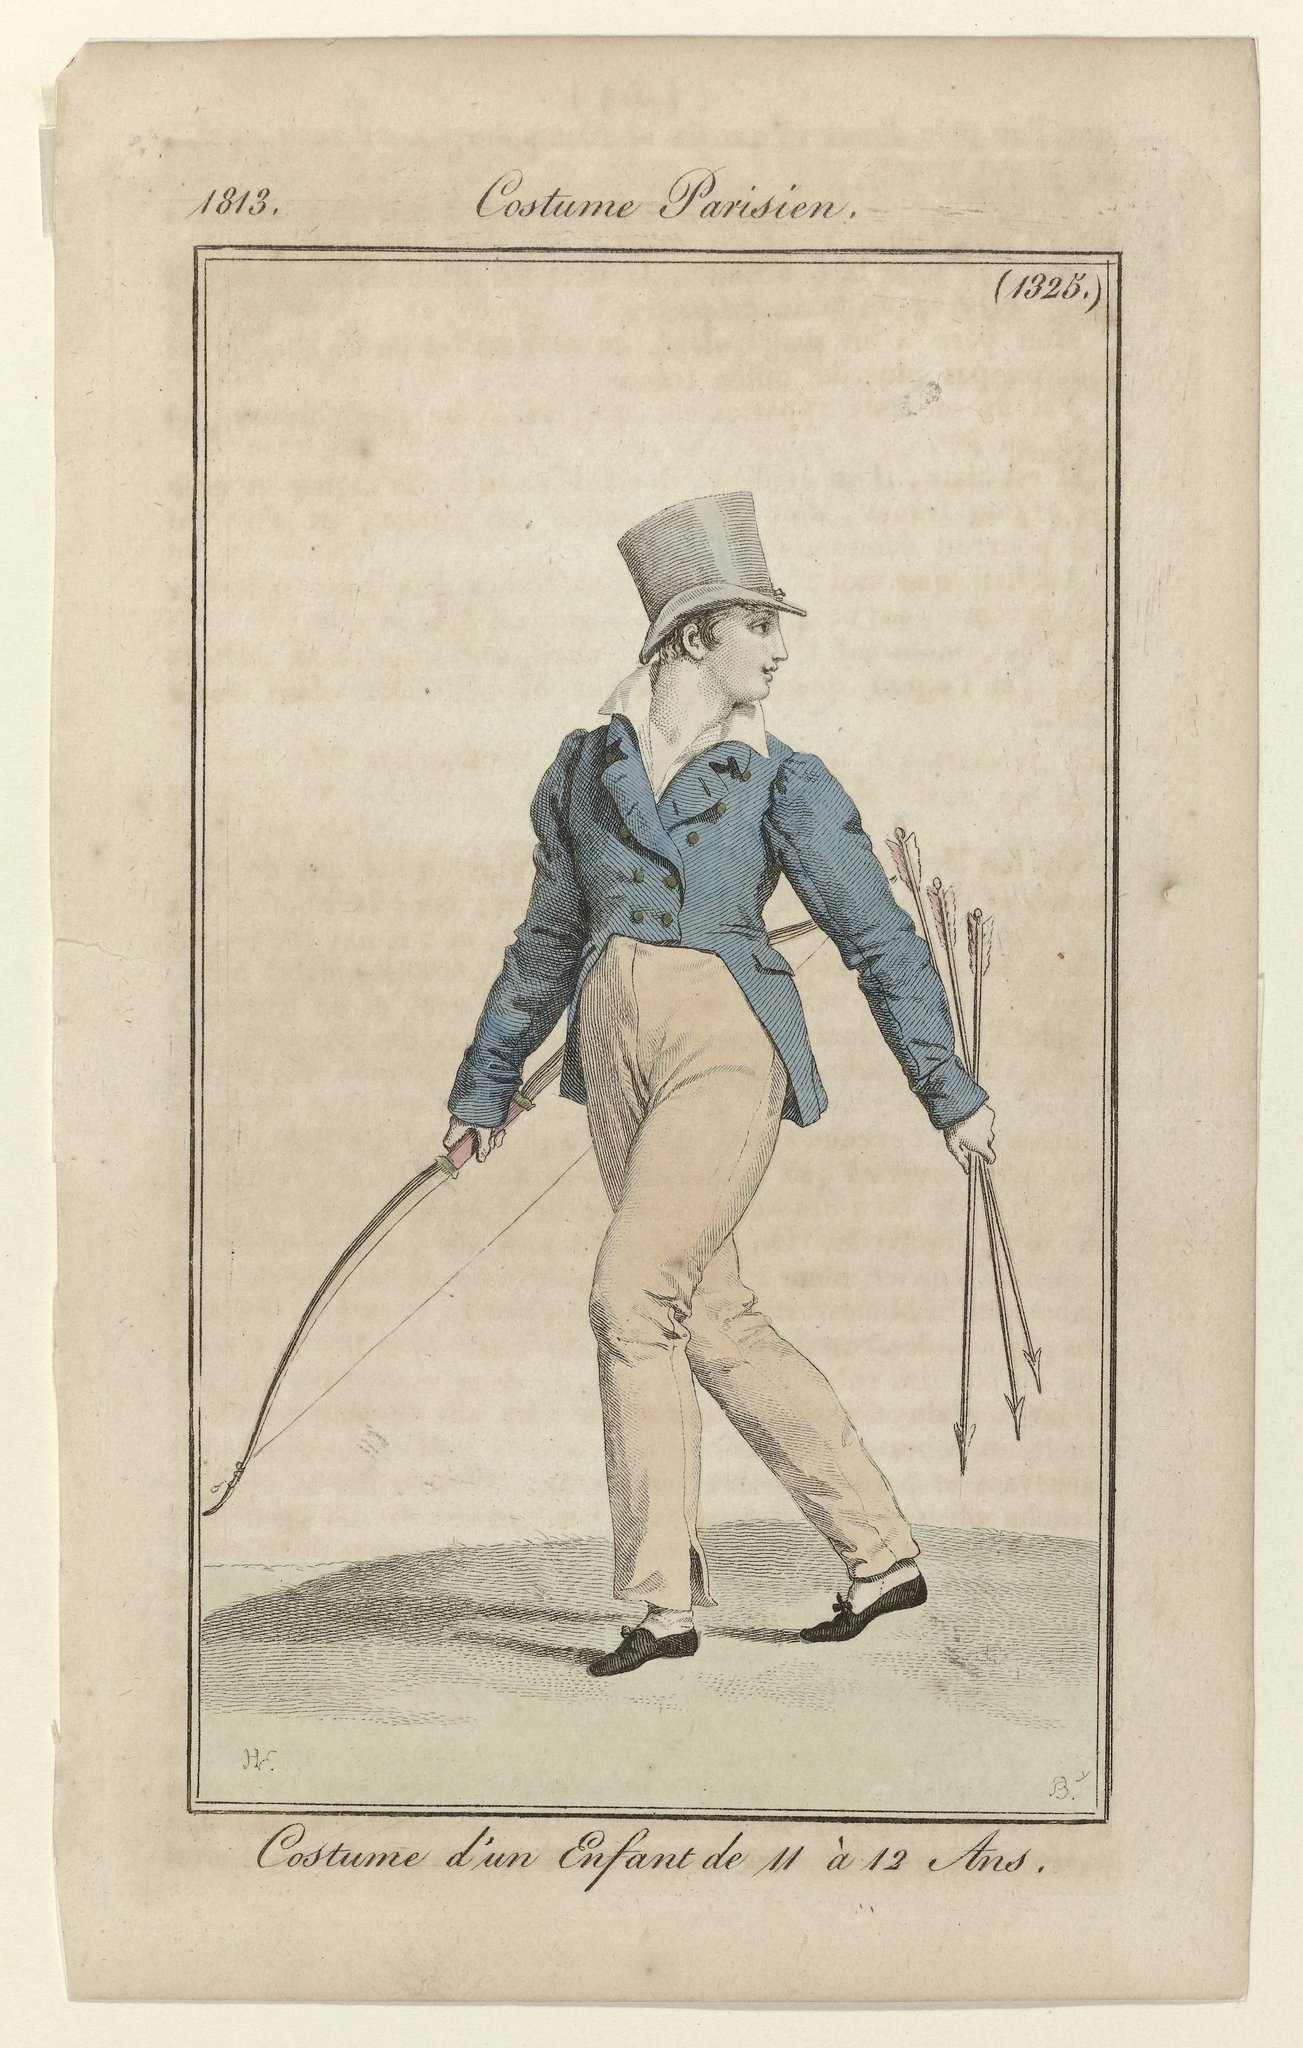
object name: fashion print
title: Journal des Dames et des Modes, Costume Parisien, 15 juillet 1813, (1325): Costume d'un Enfant (...)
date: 1813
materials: paper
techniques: engraving, hand coloring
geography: paris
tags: trousers, breeches (+ boys' clothes), shoes, sandals (+ boys' clothes), clothing for the upper part of the body (+ boys' clothes), coat (+ boys' clothes), fashion plates, archer's weapons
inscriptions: caption: ‘Costume d'un Enfant de 11 à 12 Ans.’, title: ‘Costume Parisien.’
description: Jongen, lopend naar links, gekleed in een kostuum geschikt voor een kind van elf tot twaalf jaar oud. Hij draagt een frak, hemd en lange broek. Op het hoofd een hoge hoed. platte schoenen met strikken. Boog en drie pijlen in de handen. De prent maakt deel uit van het modetijdschrift Journal des Dames et des Modes, uitgegeven door Pierre de la Mésangère, Parijs, 1797-1839.